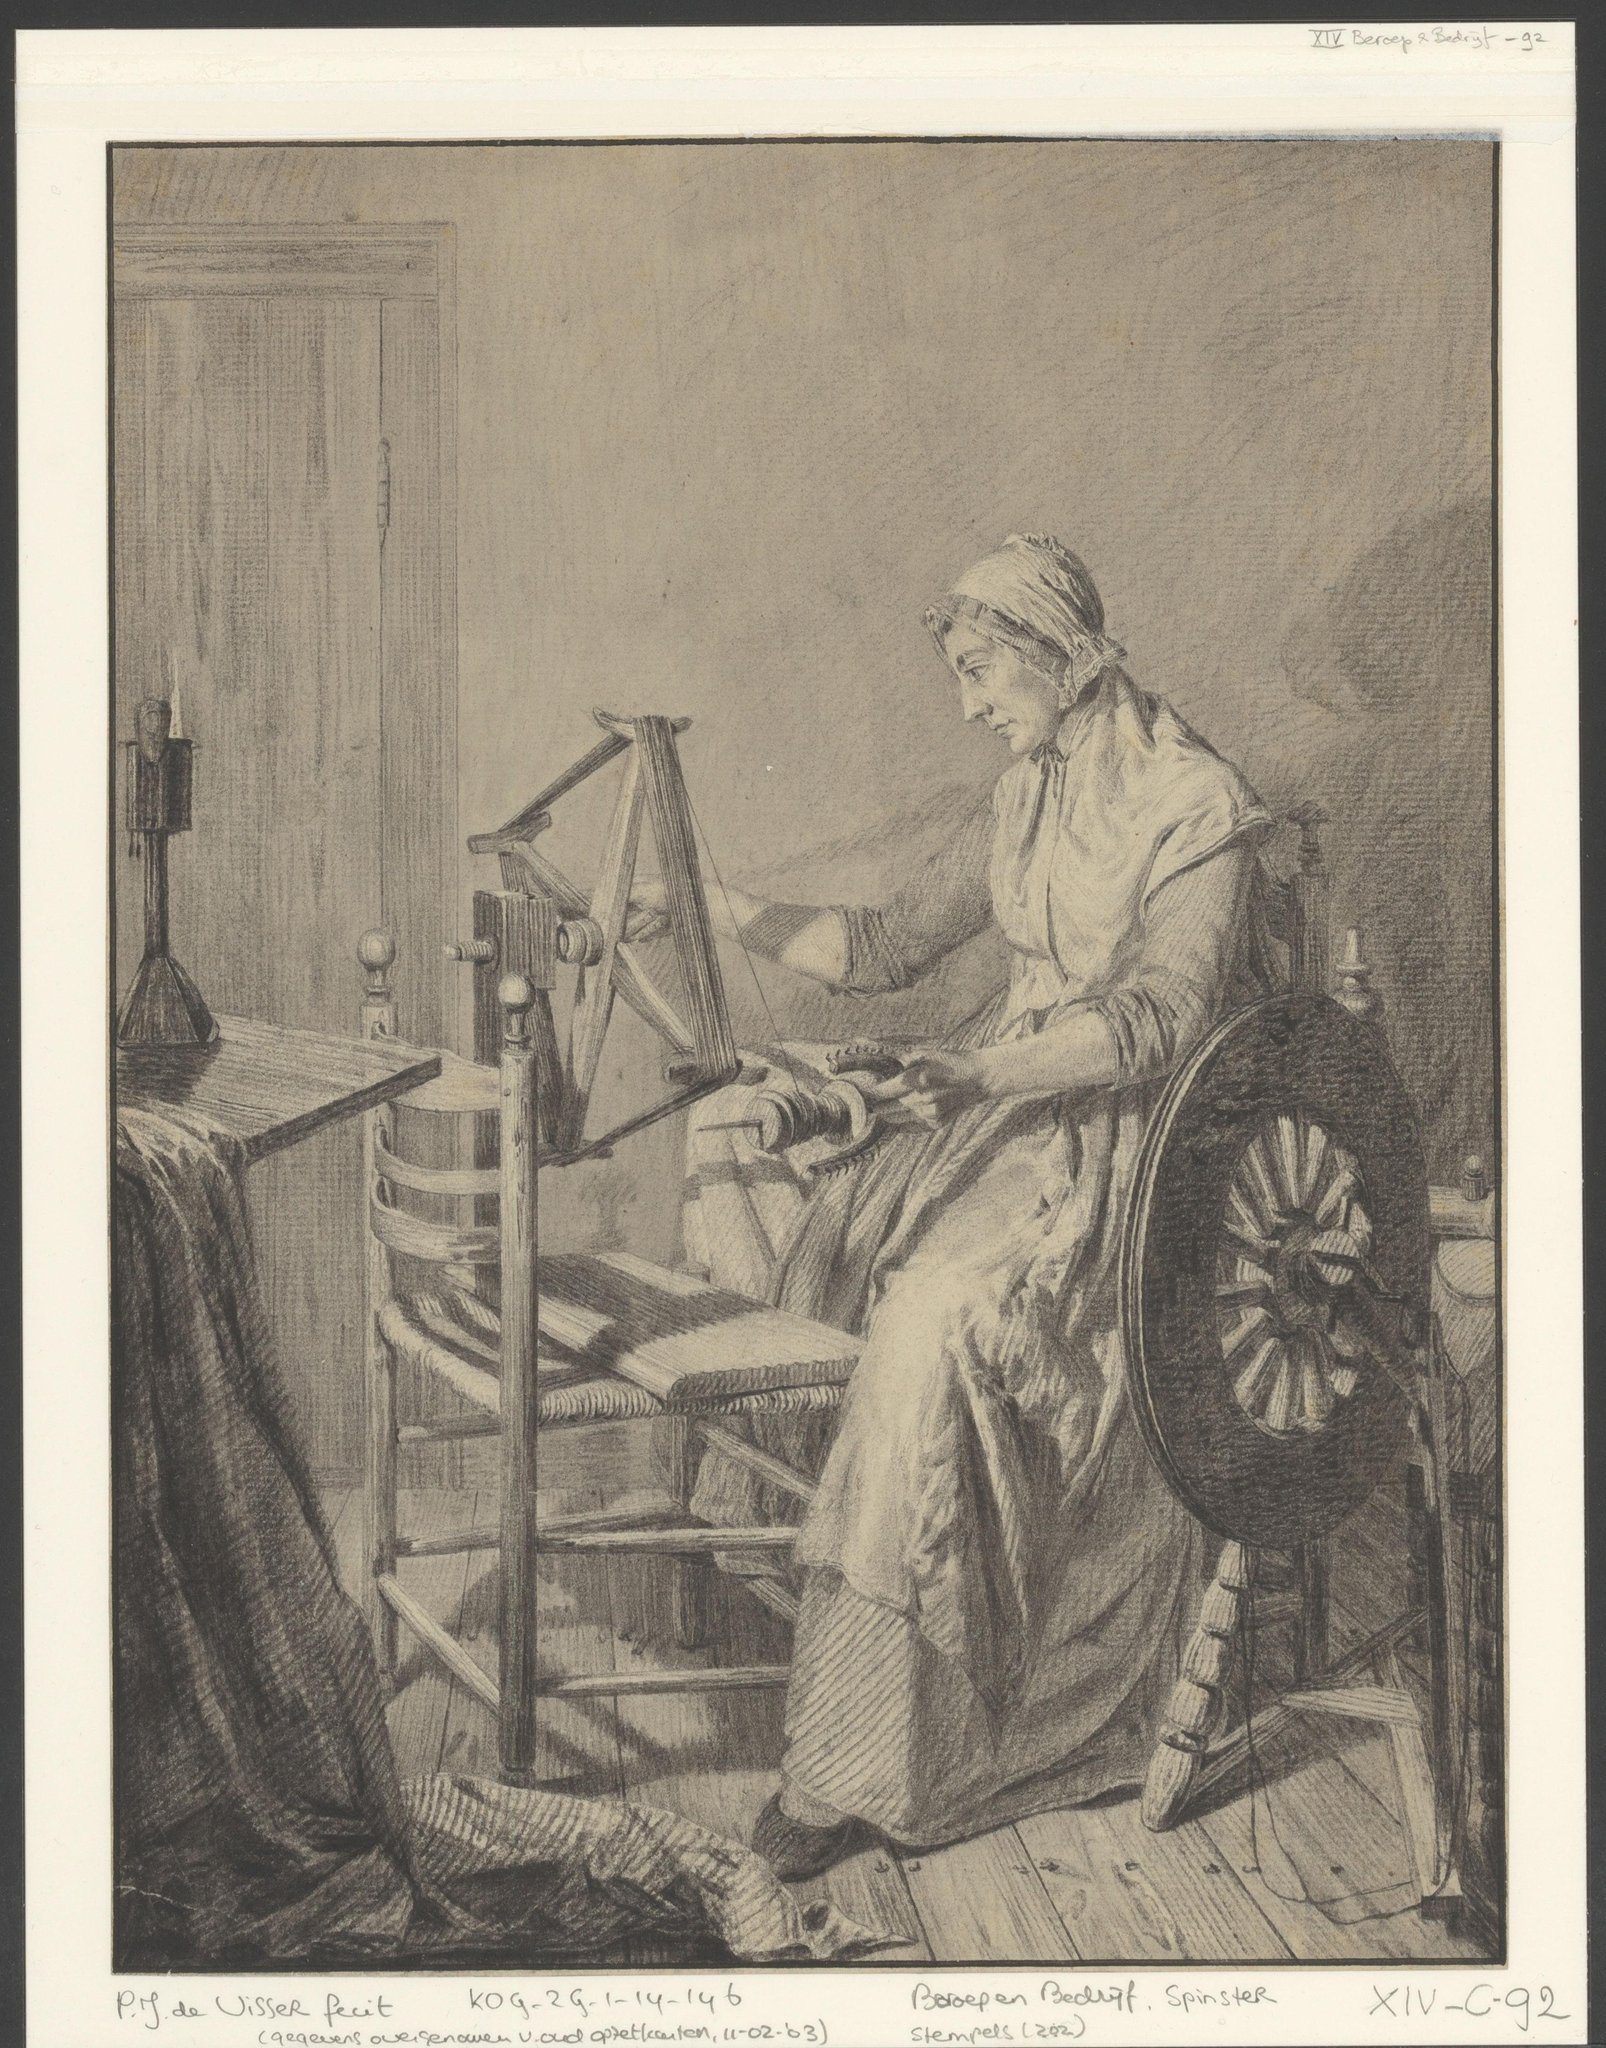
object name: drawing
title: Spinster aan een molenhaspel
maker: pier johannes de visser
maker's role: draughtsman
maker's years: 1764-1848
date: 1785-1848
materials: chalk, paper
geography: netherlands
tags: spinning-wheel, winding of yarn on reels or spools, spinning (manufacture of yarn)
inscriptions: collector's mark: Lugt 1641, collector's mark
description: Een vrouw bezig een draad van een klos op een molenhaspel te winden. Naast haar een spinnenwiel. Onderwerpsrubrieken binnen de Atlas Zeden en Gewoonten: Beroep en bedrijf. Vrouwelijk beroep en bedrijf. Kleding.